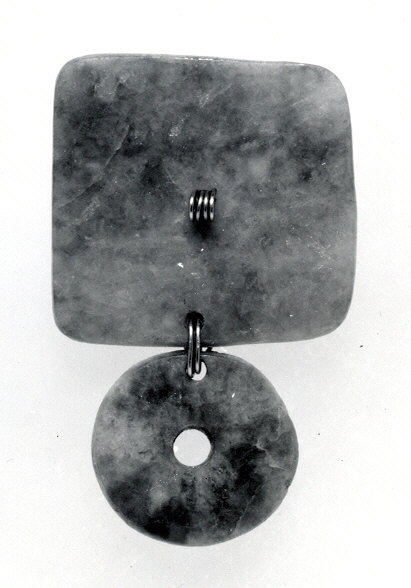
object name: ornament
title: Jade Ornament with Pendant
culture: mexican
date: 1-1500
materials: gold, jade, metal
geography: mexico